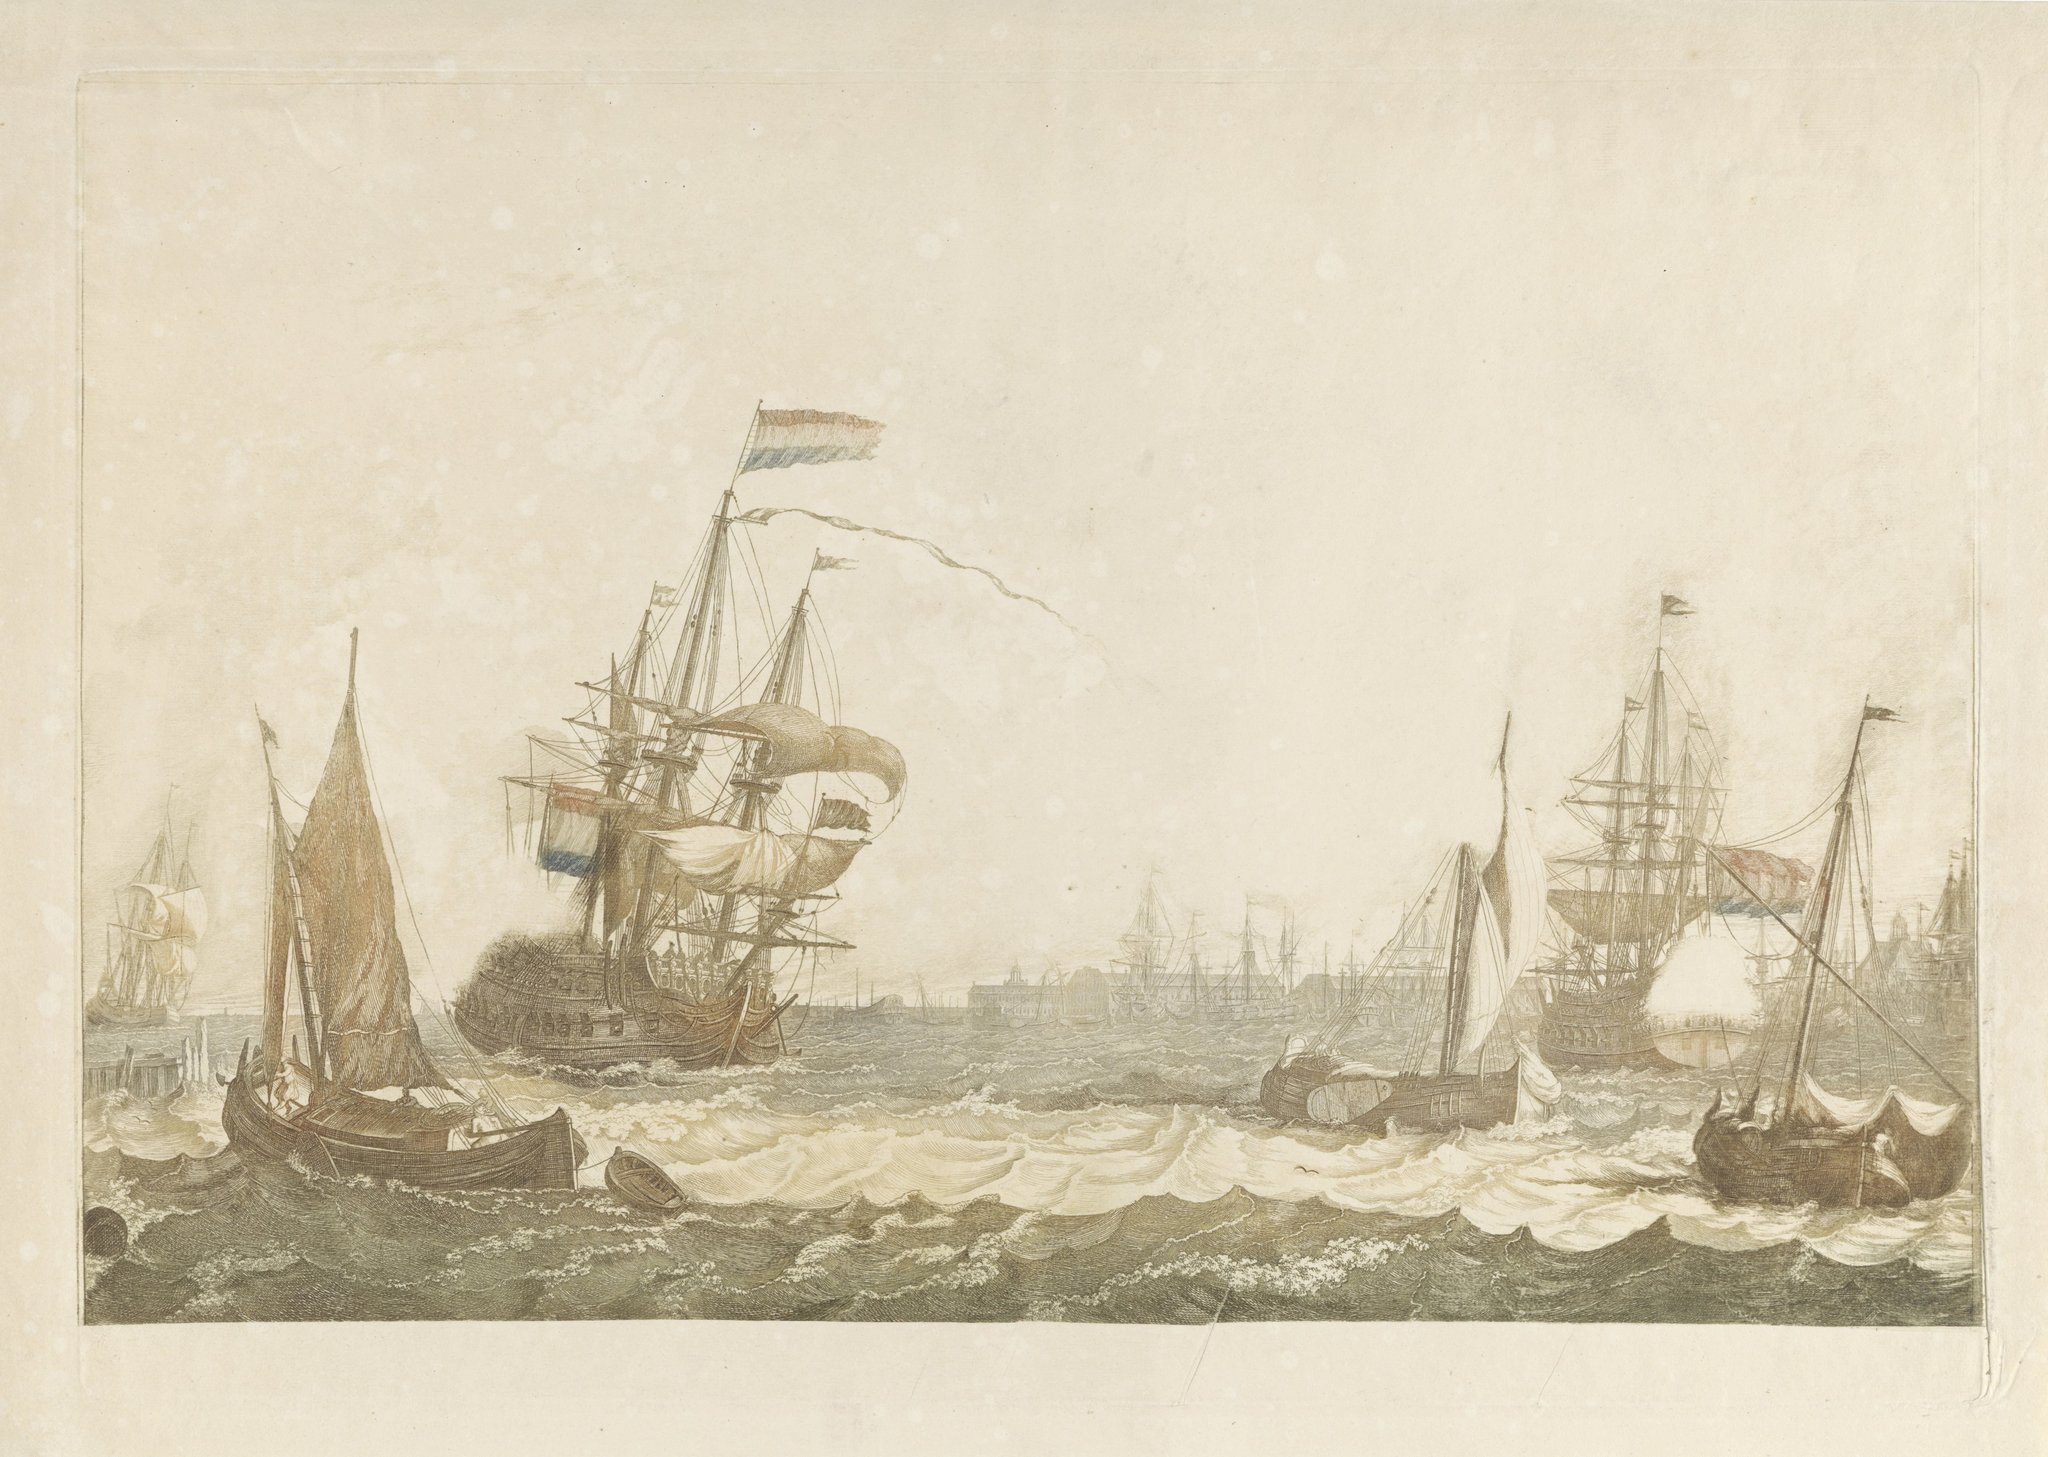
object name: print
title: Gezicht op het het IJ met het Oost-Indisch Zeemagazijn en de Oosterkerk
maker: johan teyler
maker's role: draughtsman, print maker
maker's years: 1648-1712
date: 1750-1825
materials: paper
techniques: etching, lithography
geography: netherlands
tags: sailing-ship, sailing-boat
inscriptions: collector's mark: Lugt 2228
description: Zeilschepen op het IJ met op de achtergrond het Oost-Indisch Zeemagazijn en de Oosterkerk.